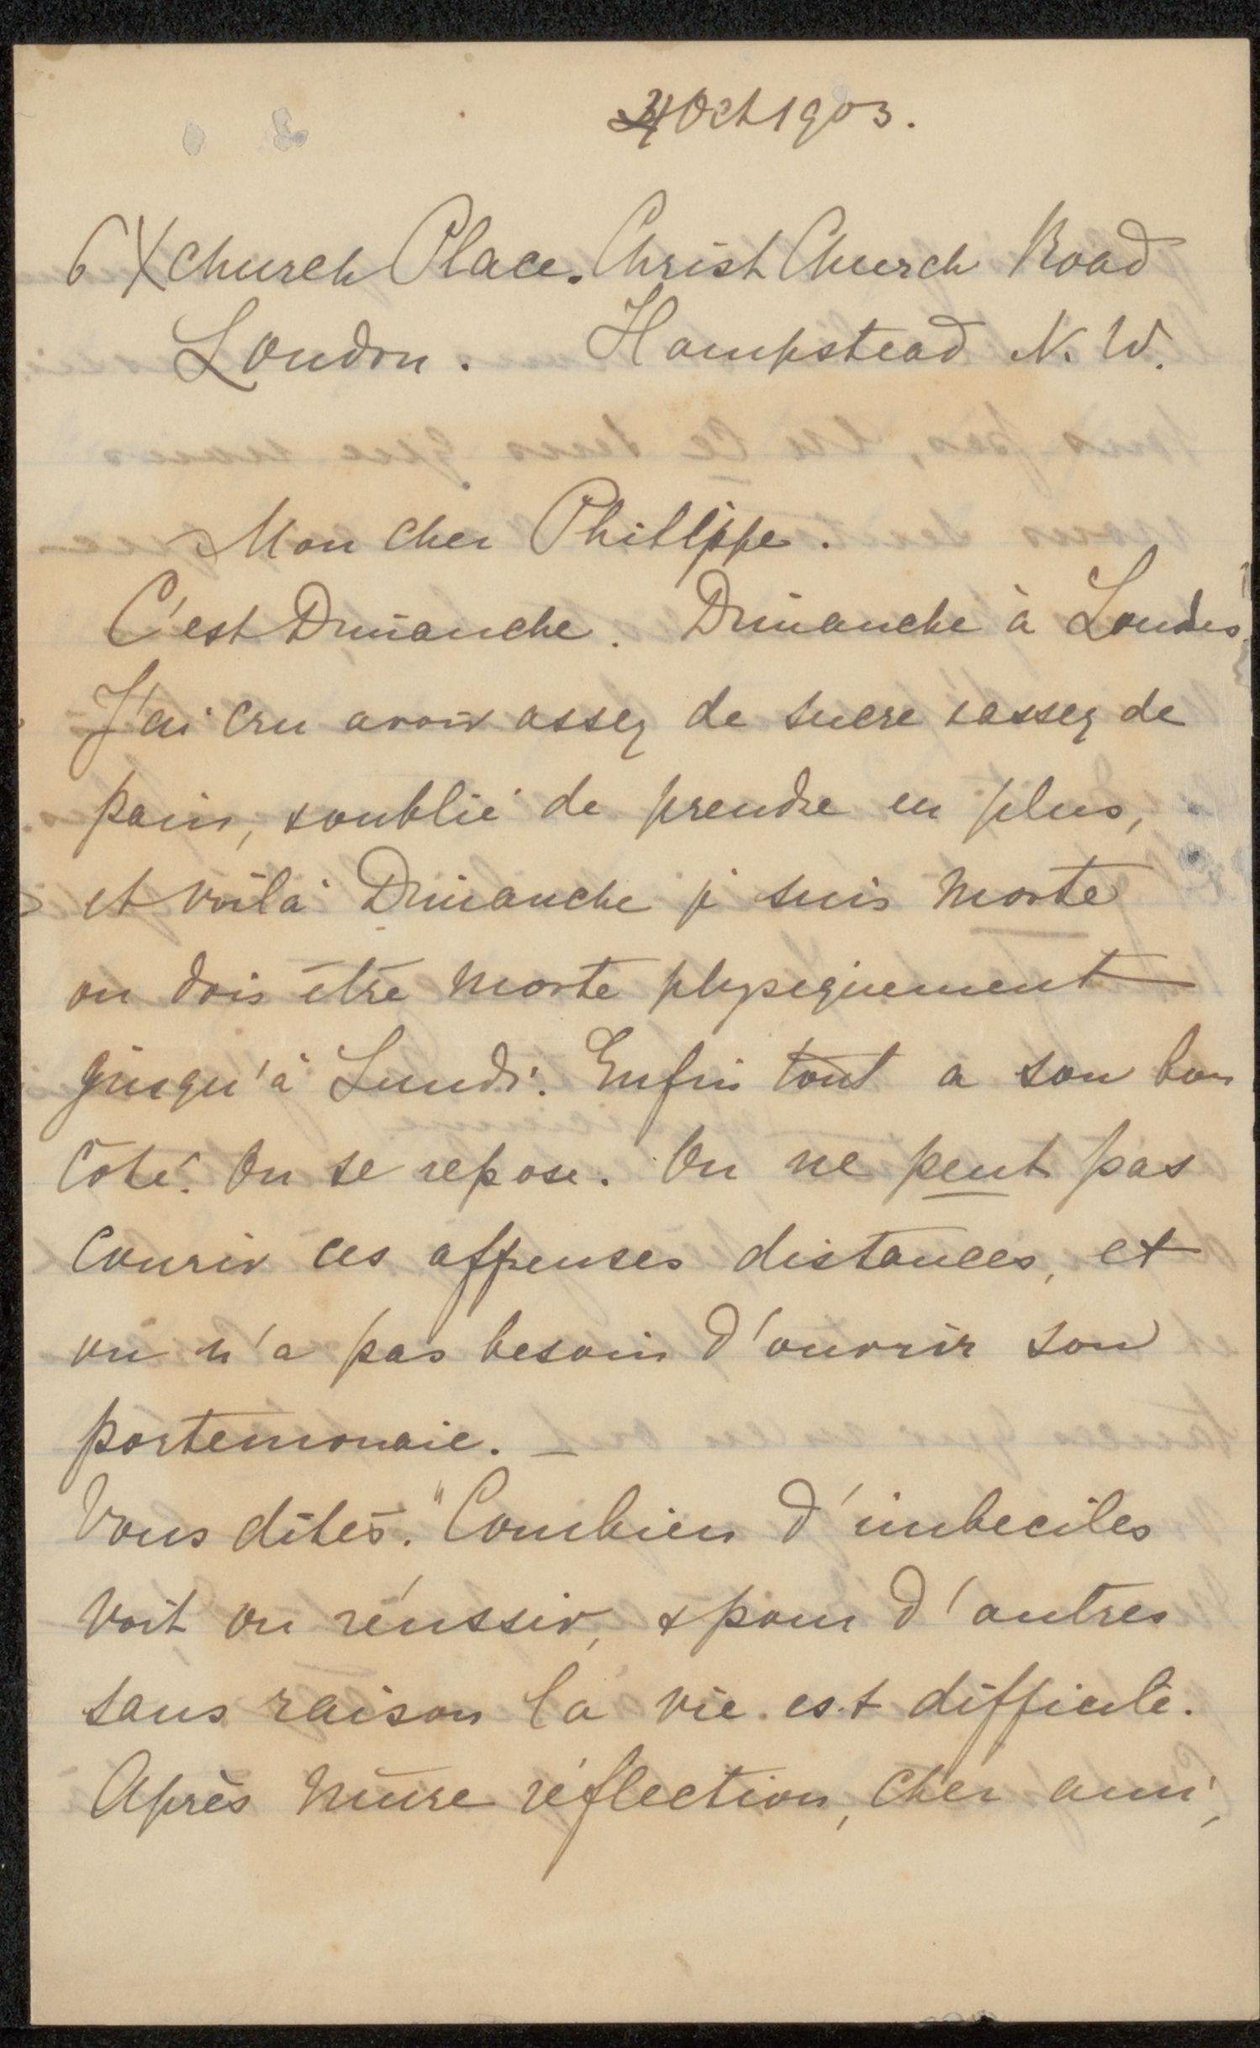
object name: letter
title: Brief aan Philip Zilcken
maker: ernestine hadkinson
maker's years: 1863-1928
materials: ink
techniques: pen, writing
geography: hampstead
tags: the hague, painter, draughtsman, philip zilcken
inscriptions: collector's mark: ‘RPK’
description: Vormt samen met RP-D-1982-43-HADKINSON(E.)-6B en RP-D-1982-43-HADKINSON(E.)-6C een doorlopende brief.